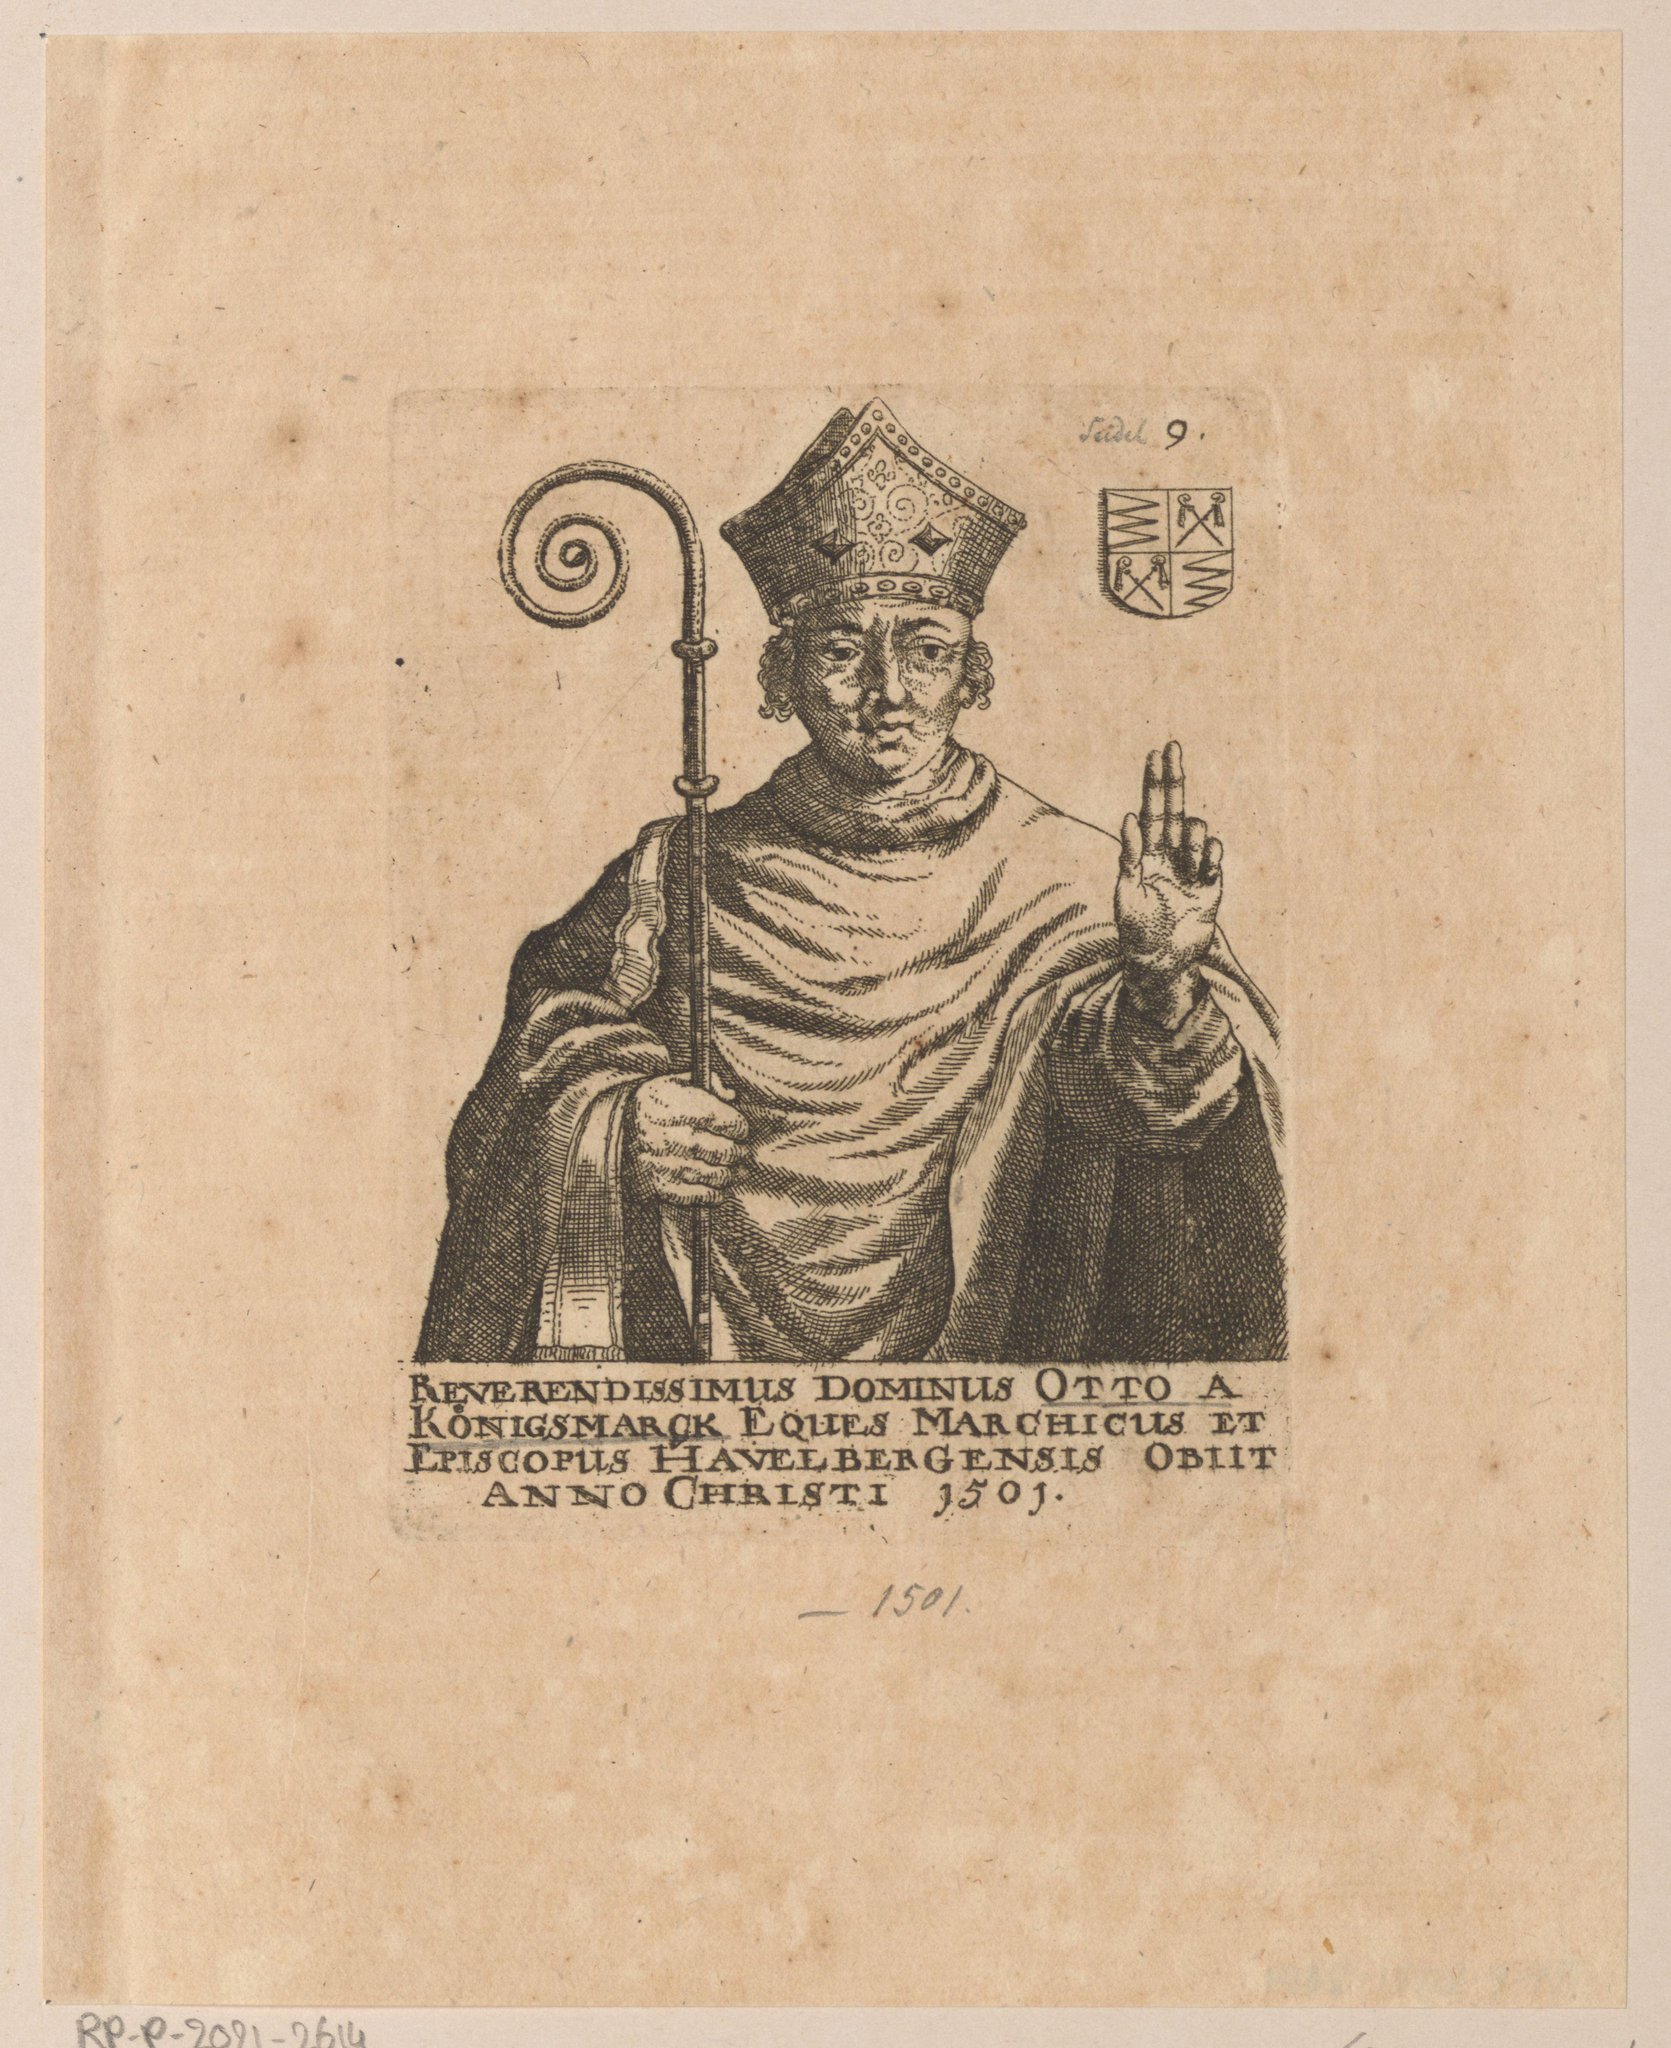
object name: print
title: Icones et elogia virorum aliquot praestantium (...)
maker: Anonymous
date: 1671-1751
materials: paper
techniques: etching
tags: archbishop, bishop, etc. (roman catholic), historical persons, armorial bearing, heraldry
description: De prent is uitgegeven als onderdeel van een serie. Later is de prent mogelijk ook als boekillustratie gebruikt in: Küster, Georg Gottfried. Martin Friedrich Seidels Bilder-Sammlung in welcher hundert, gröstentheils in der Mark Brandenburg (…). Berlijn: Buchladen bey der Real-Schule, 1751. Het is onduidelijk tot welke uitgave de huidige prent behoort.